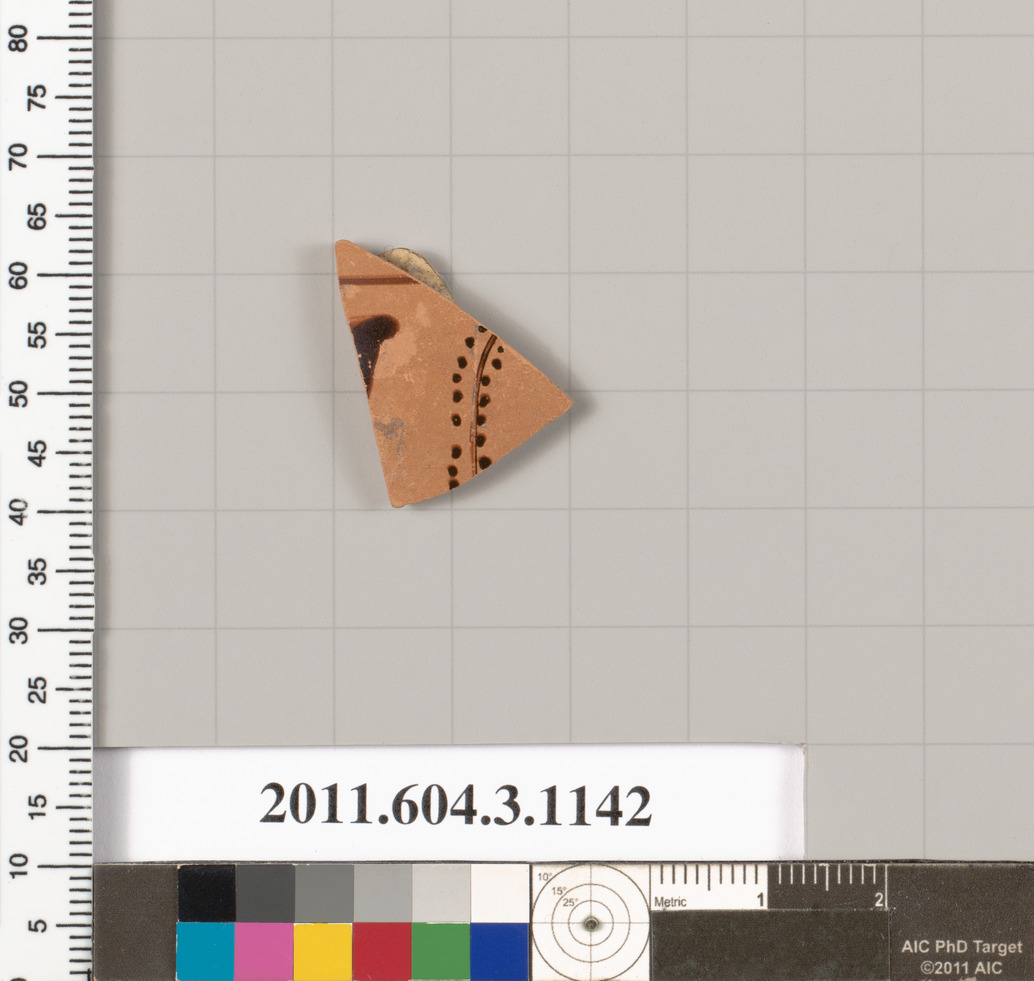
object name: mastoid or kyathos fragment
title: Terracotta fragment of a mastoid (drinking cup with narrow base) or a kyathos (cup-shaped ladle)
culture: greek, attic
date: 534-468 BCE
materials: terracotta